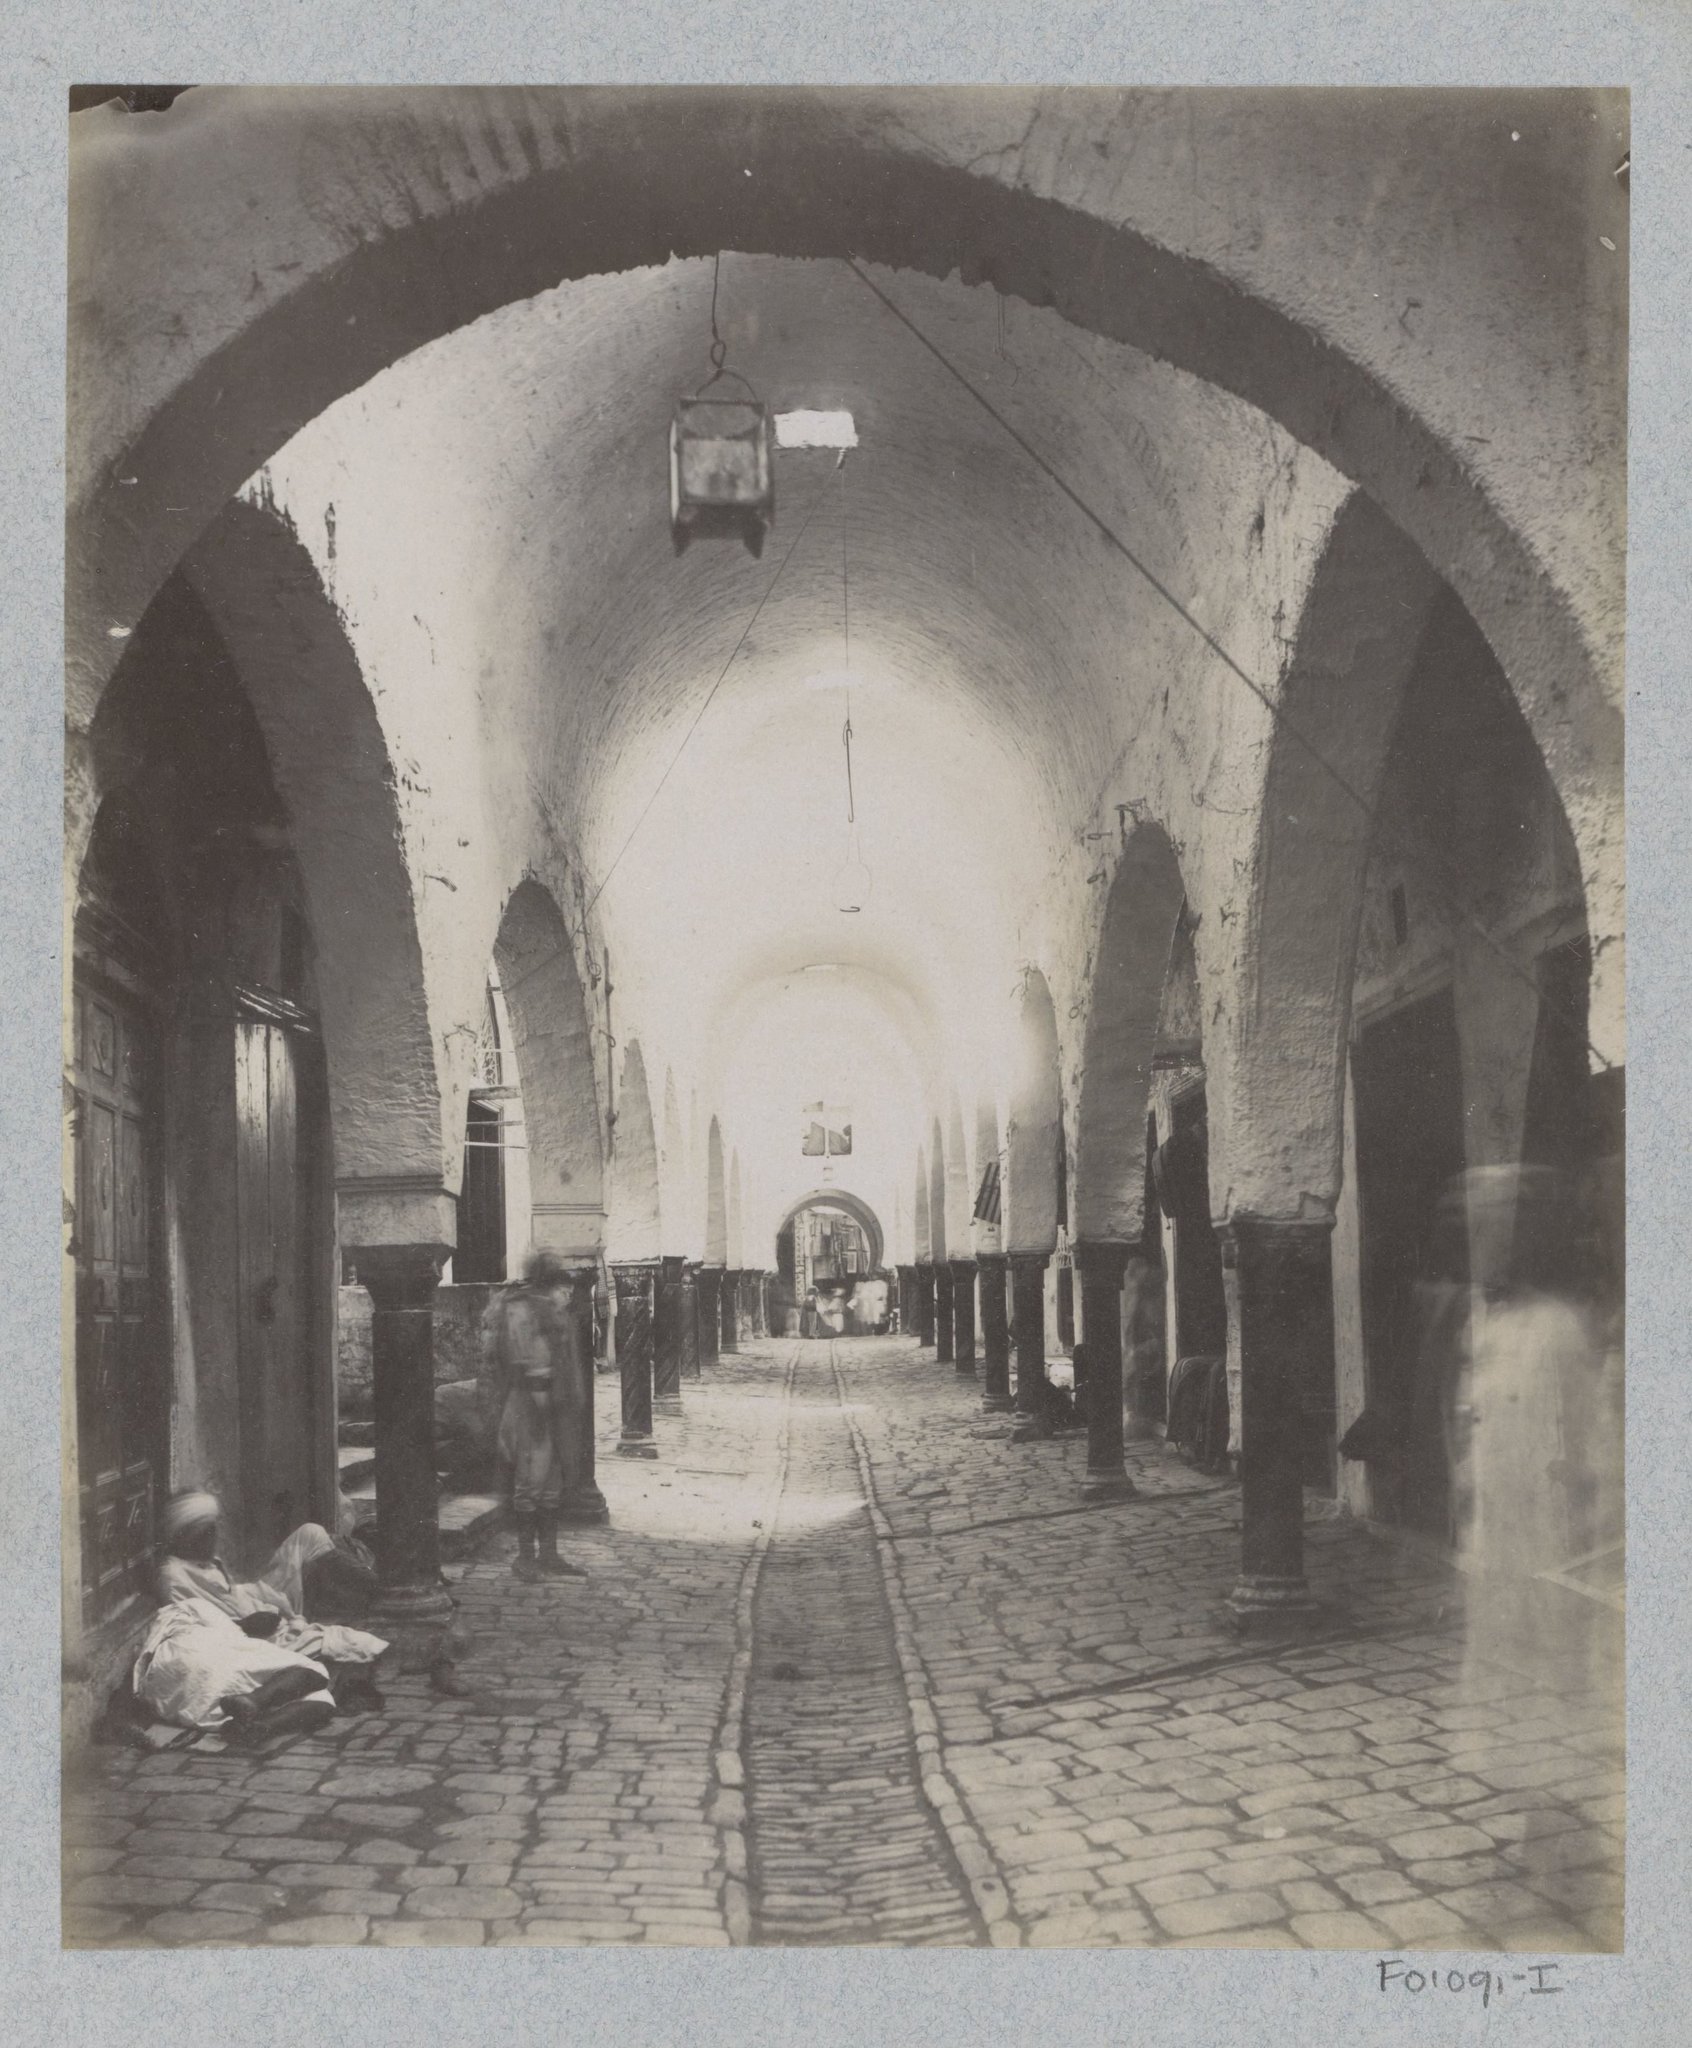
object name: album leaf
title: Arcade met liggende figuren in de souk van Tunis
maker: Anonymous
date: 1880-1900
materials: paper, photographic support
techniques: albumen print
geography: tunis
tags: market, arcade ~ architecture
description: Onderdeel van Reisalbum met foto's van bezienswaardigheden in Tunis en Tunesië.